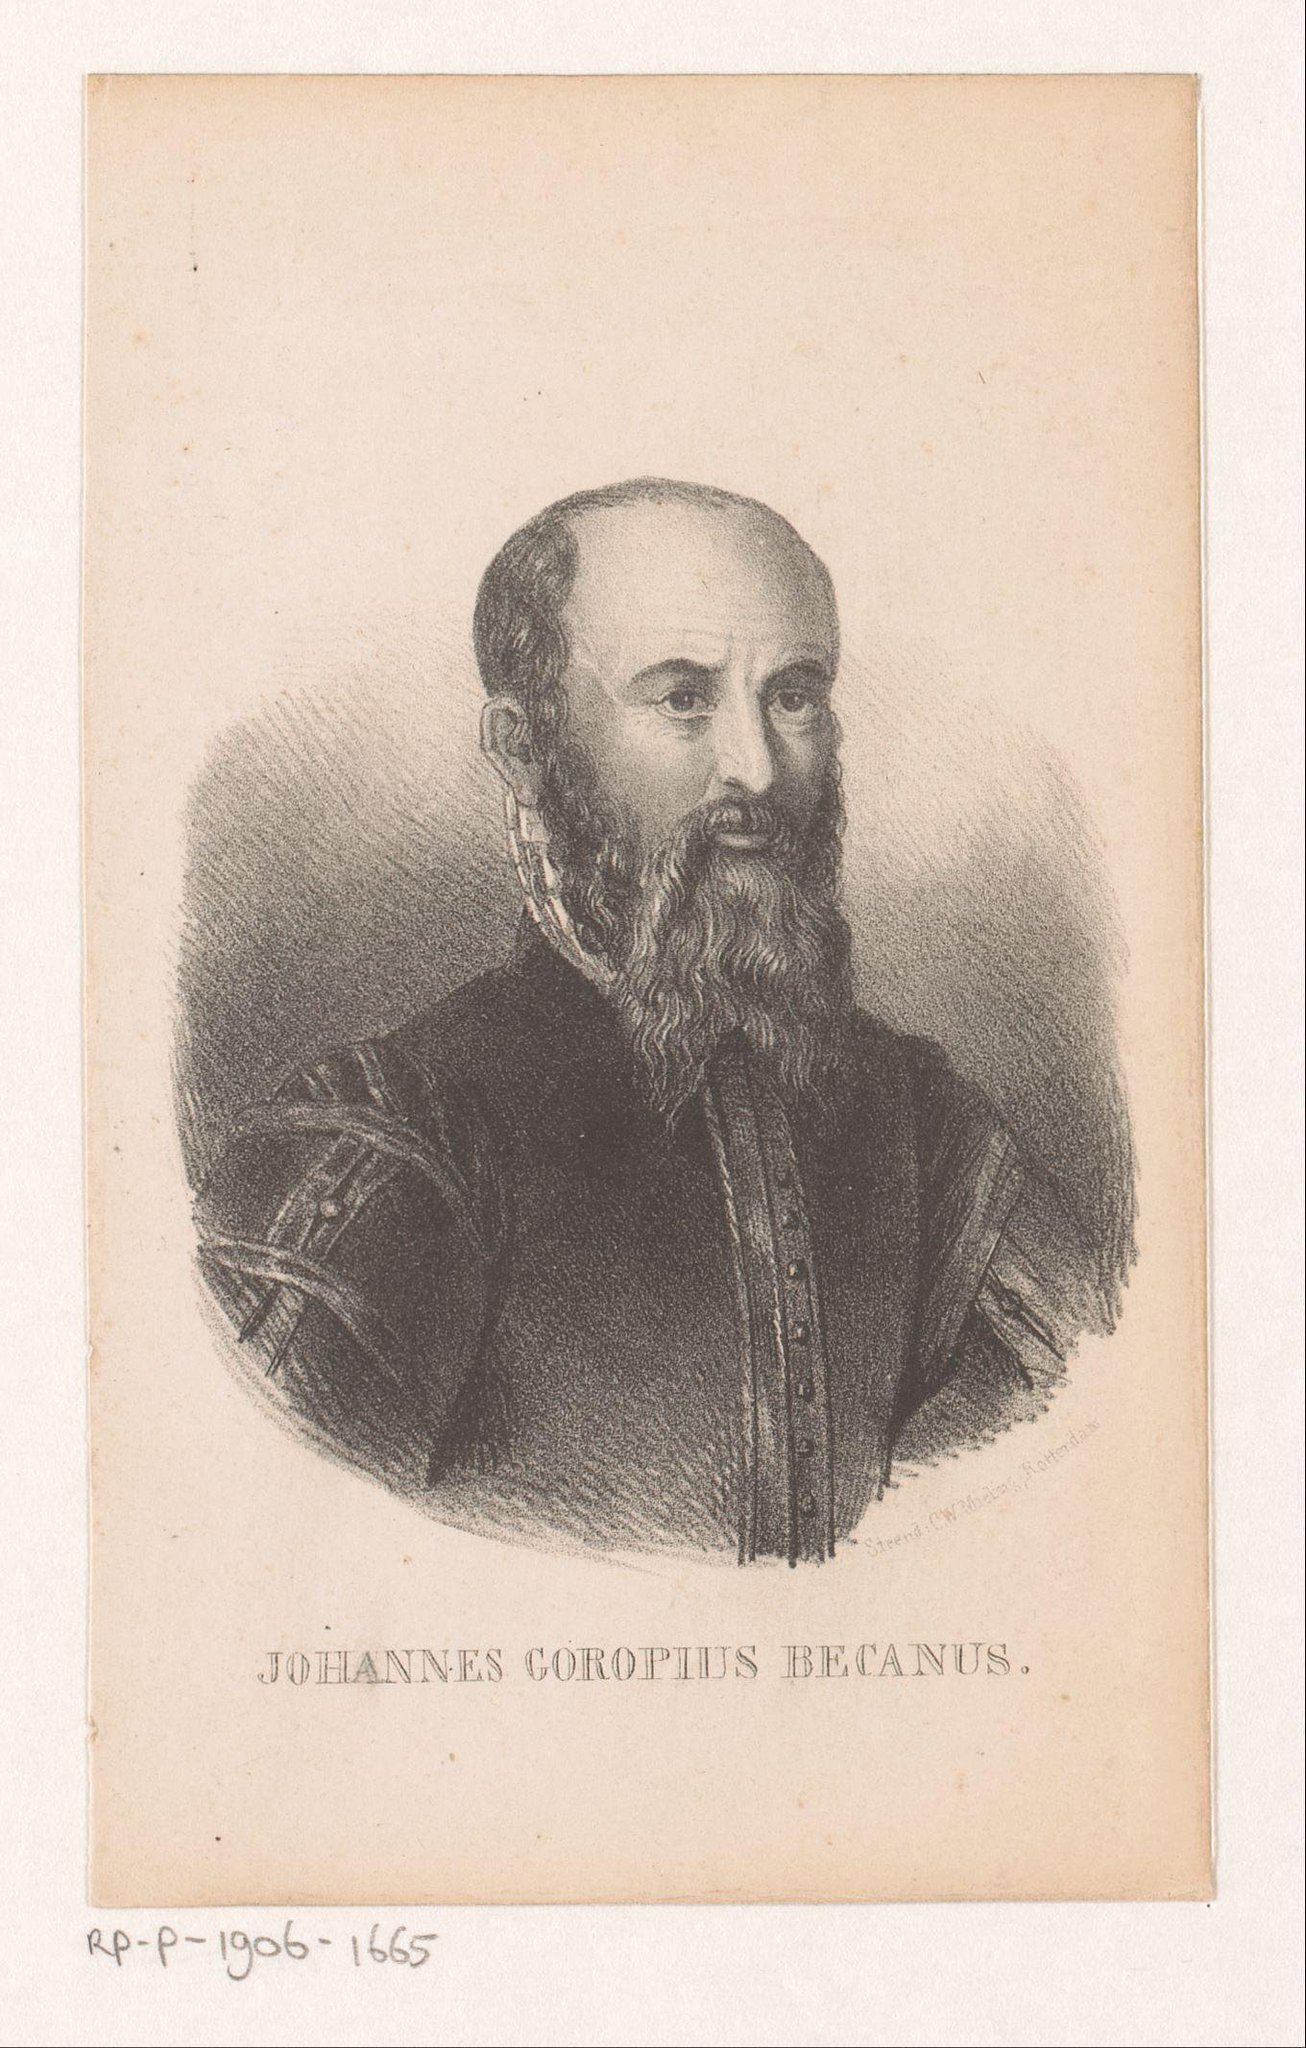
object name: print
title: Portret van Adrianus Becanus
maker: Anonymous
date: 1839-1845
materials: paper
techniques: lithograph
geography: rotterdam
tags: brielle, historical persons (+ (full) bust portrait)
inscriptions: collector's mark: Lugt 2228